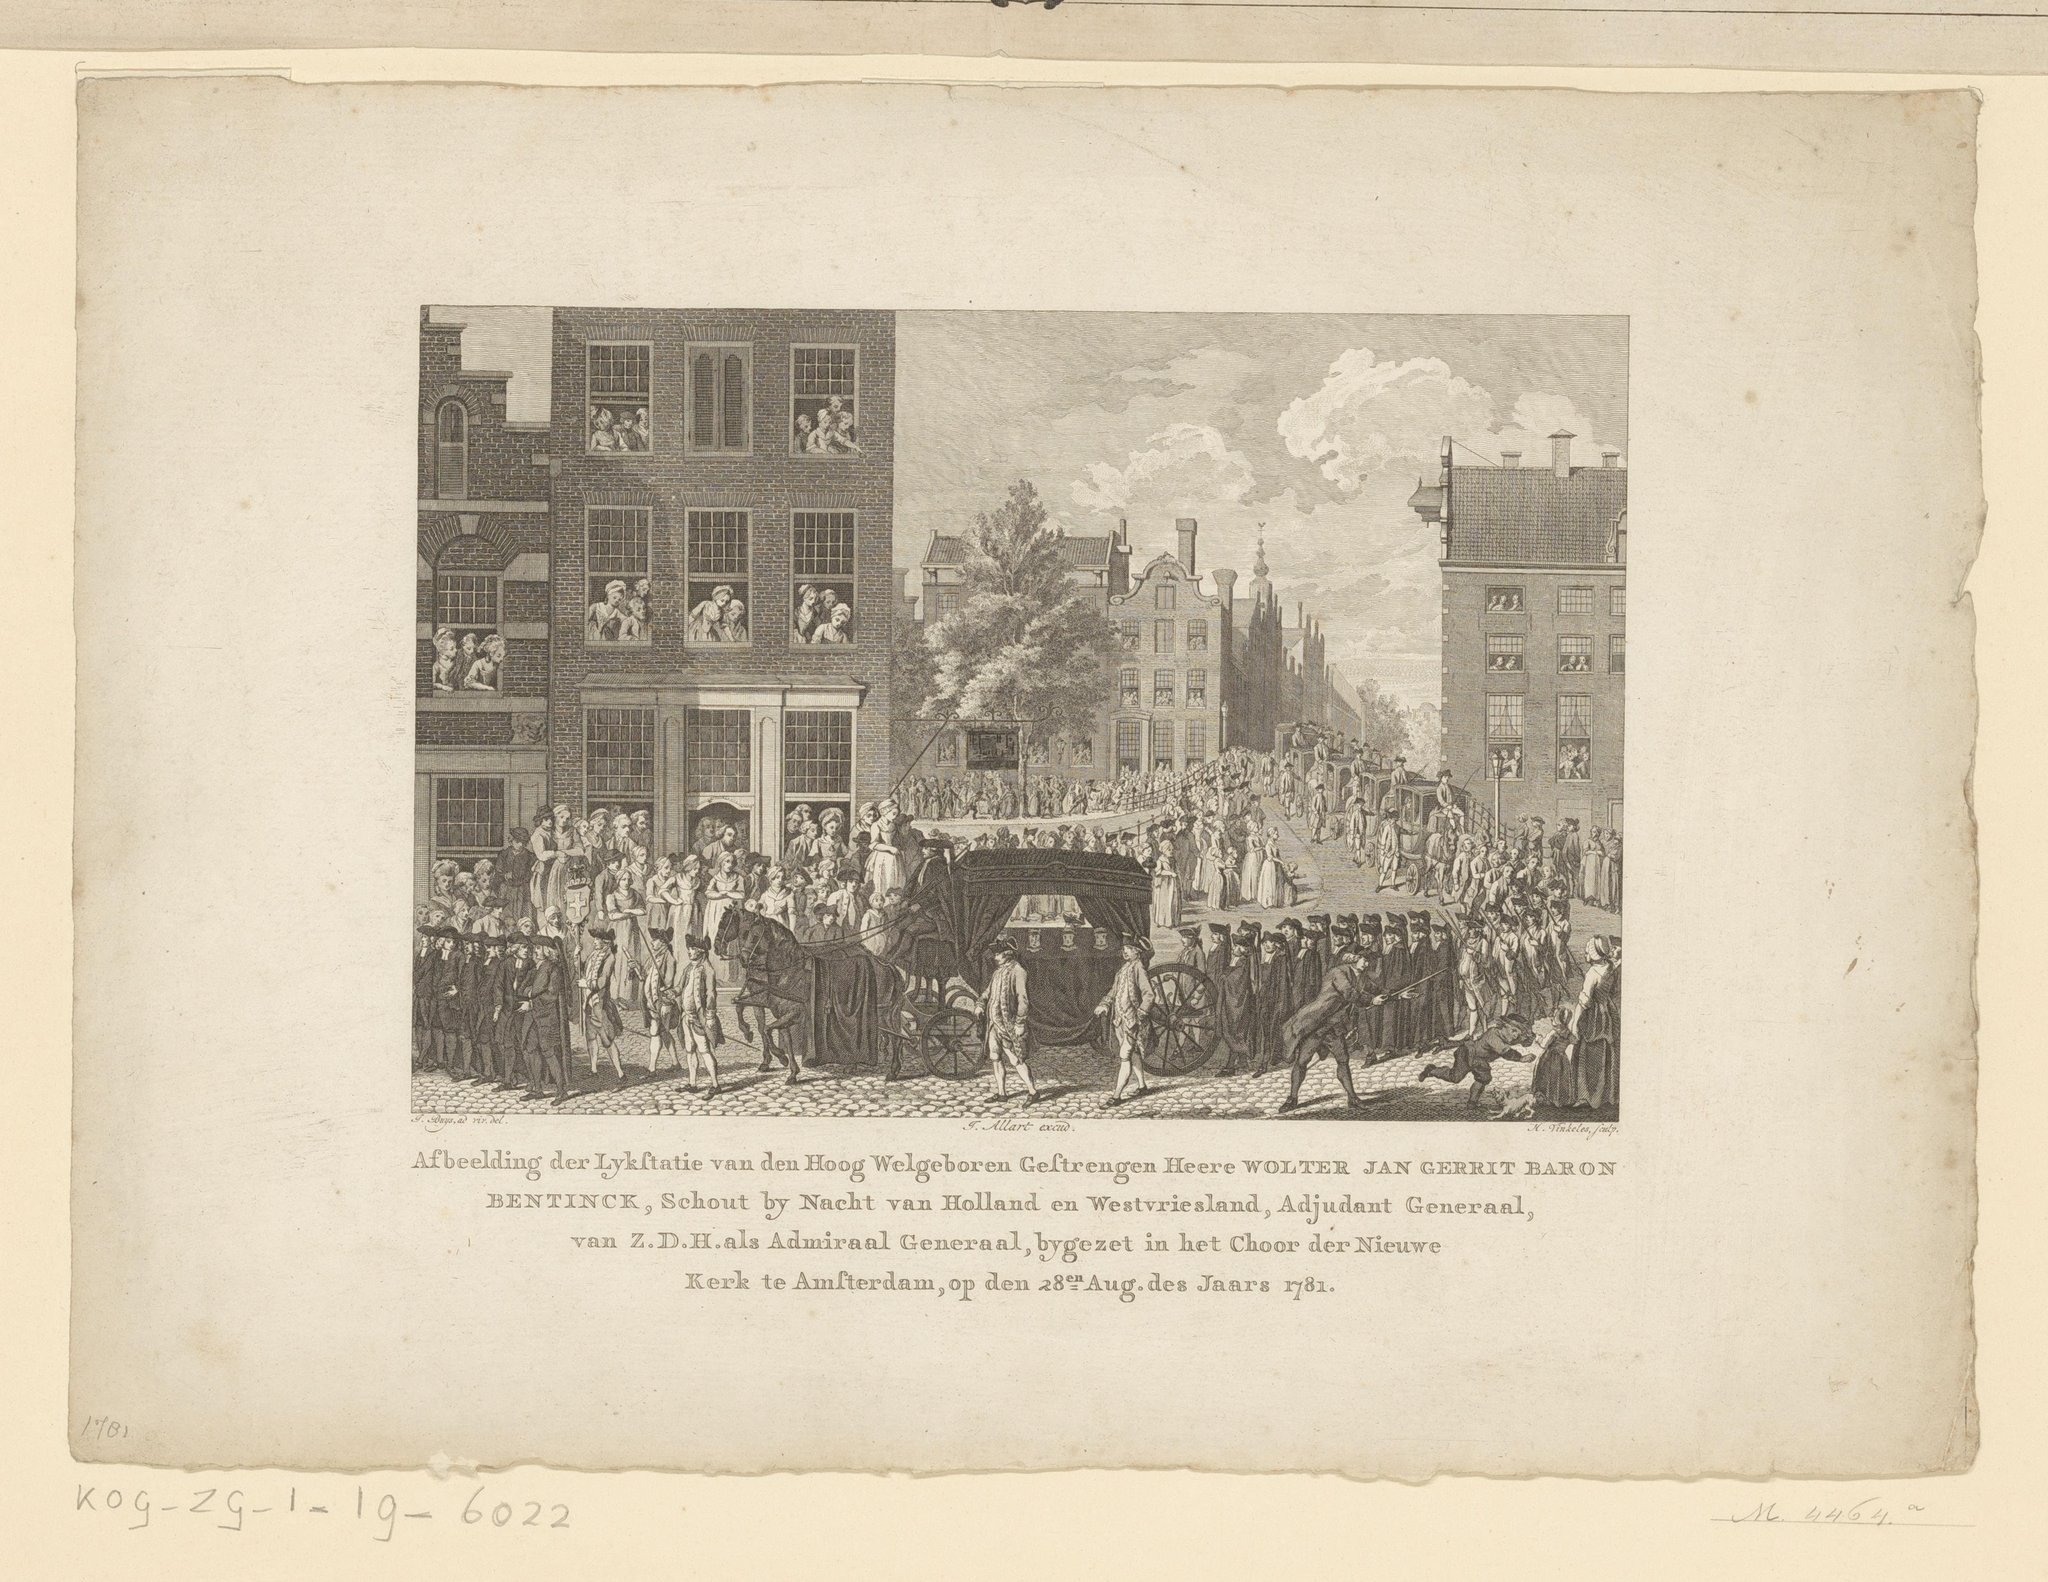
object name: print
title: Afbeelding der lykstatie van den Hoog Welgeboren Gestrengen Heere Wolter Jan Gerrit baron Bentinck (...) bygezet in het choor der Nieuwe Kerk te Amsterdam, op den 28en. aug. des jaars 1781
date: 1782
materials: paper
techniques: engraving, etching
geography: amsterdam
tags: amsterdam, funeral carriages, public funeral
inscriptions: collector's mark, collector's mark: Lugt 1641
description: Lijkstatie van Wolter Jan Gerrit baron Bentinck, overleden op 23/24 augustus aan zijn verwondingen opgelopen in de zeeslag bij Doggersbank, op 28 augustus 1781 te Amsterdam. De lijkstoet komt uit de Nieuwe Doelenstraat over Muntplein en trekt de Kalverstraat in, richting de Nieuwe Kerk. Onderwerpsrubrieken binnen de Atlas Zeden en Gewoonten: Des Menschen Begin, Midden en Einde. Begrafenissen, lijkstaties.